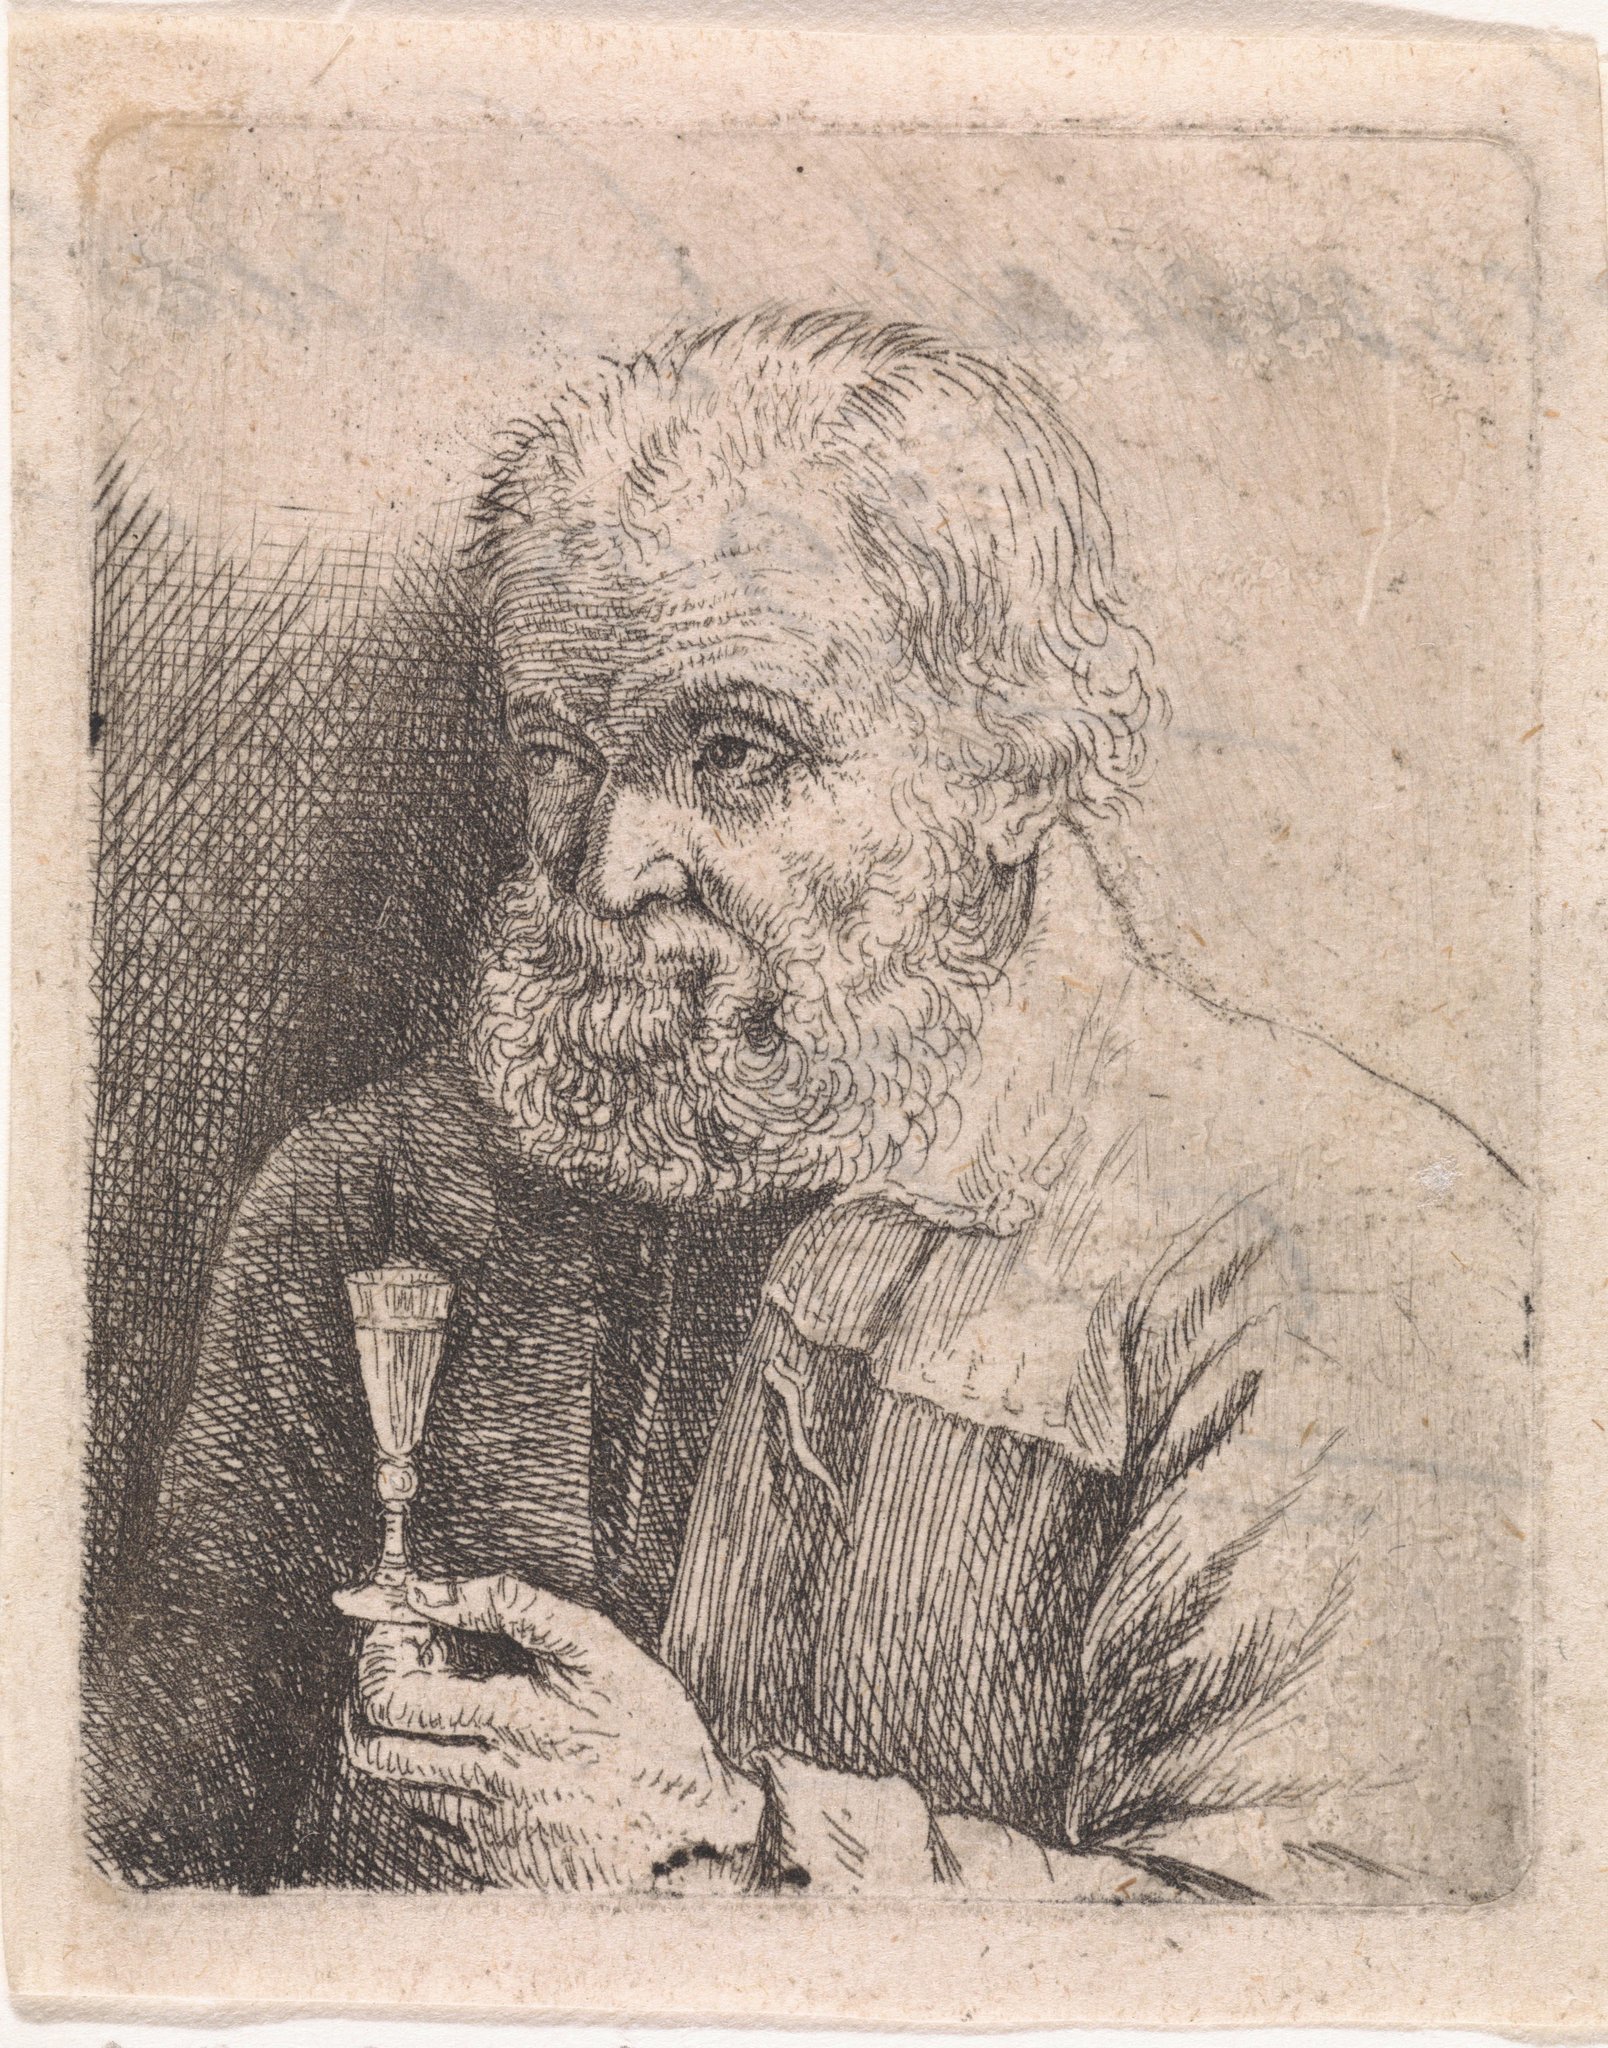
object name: print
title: De vijf zintuigen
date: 1626-1690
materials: paper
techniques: etching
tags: taste, tasting (one of the five senses)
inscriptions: collector's mark: Lugt 2228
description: Een man met een glas wijn in de hand. Personificatie van de smaak. Prent maakt deel uit van een serie van de vijf zintuigen.